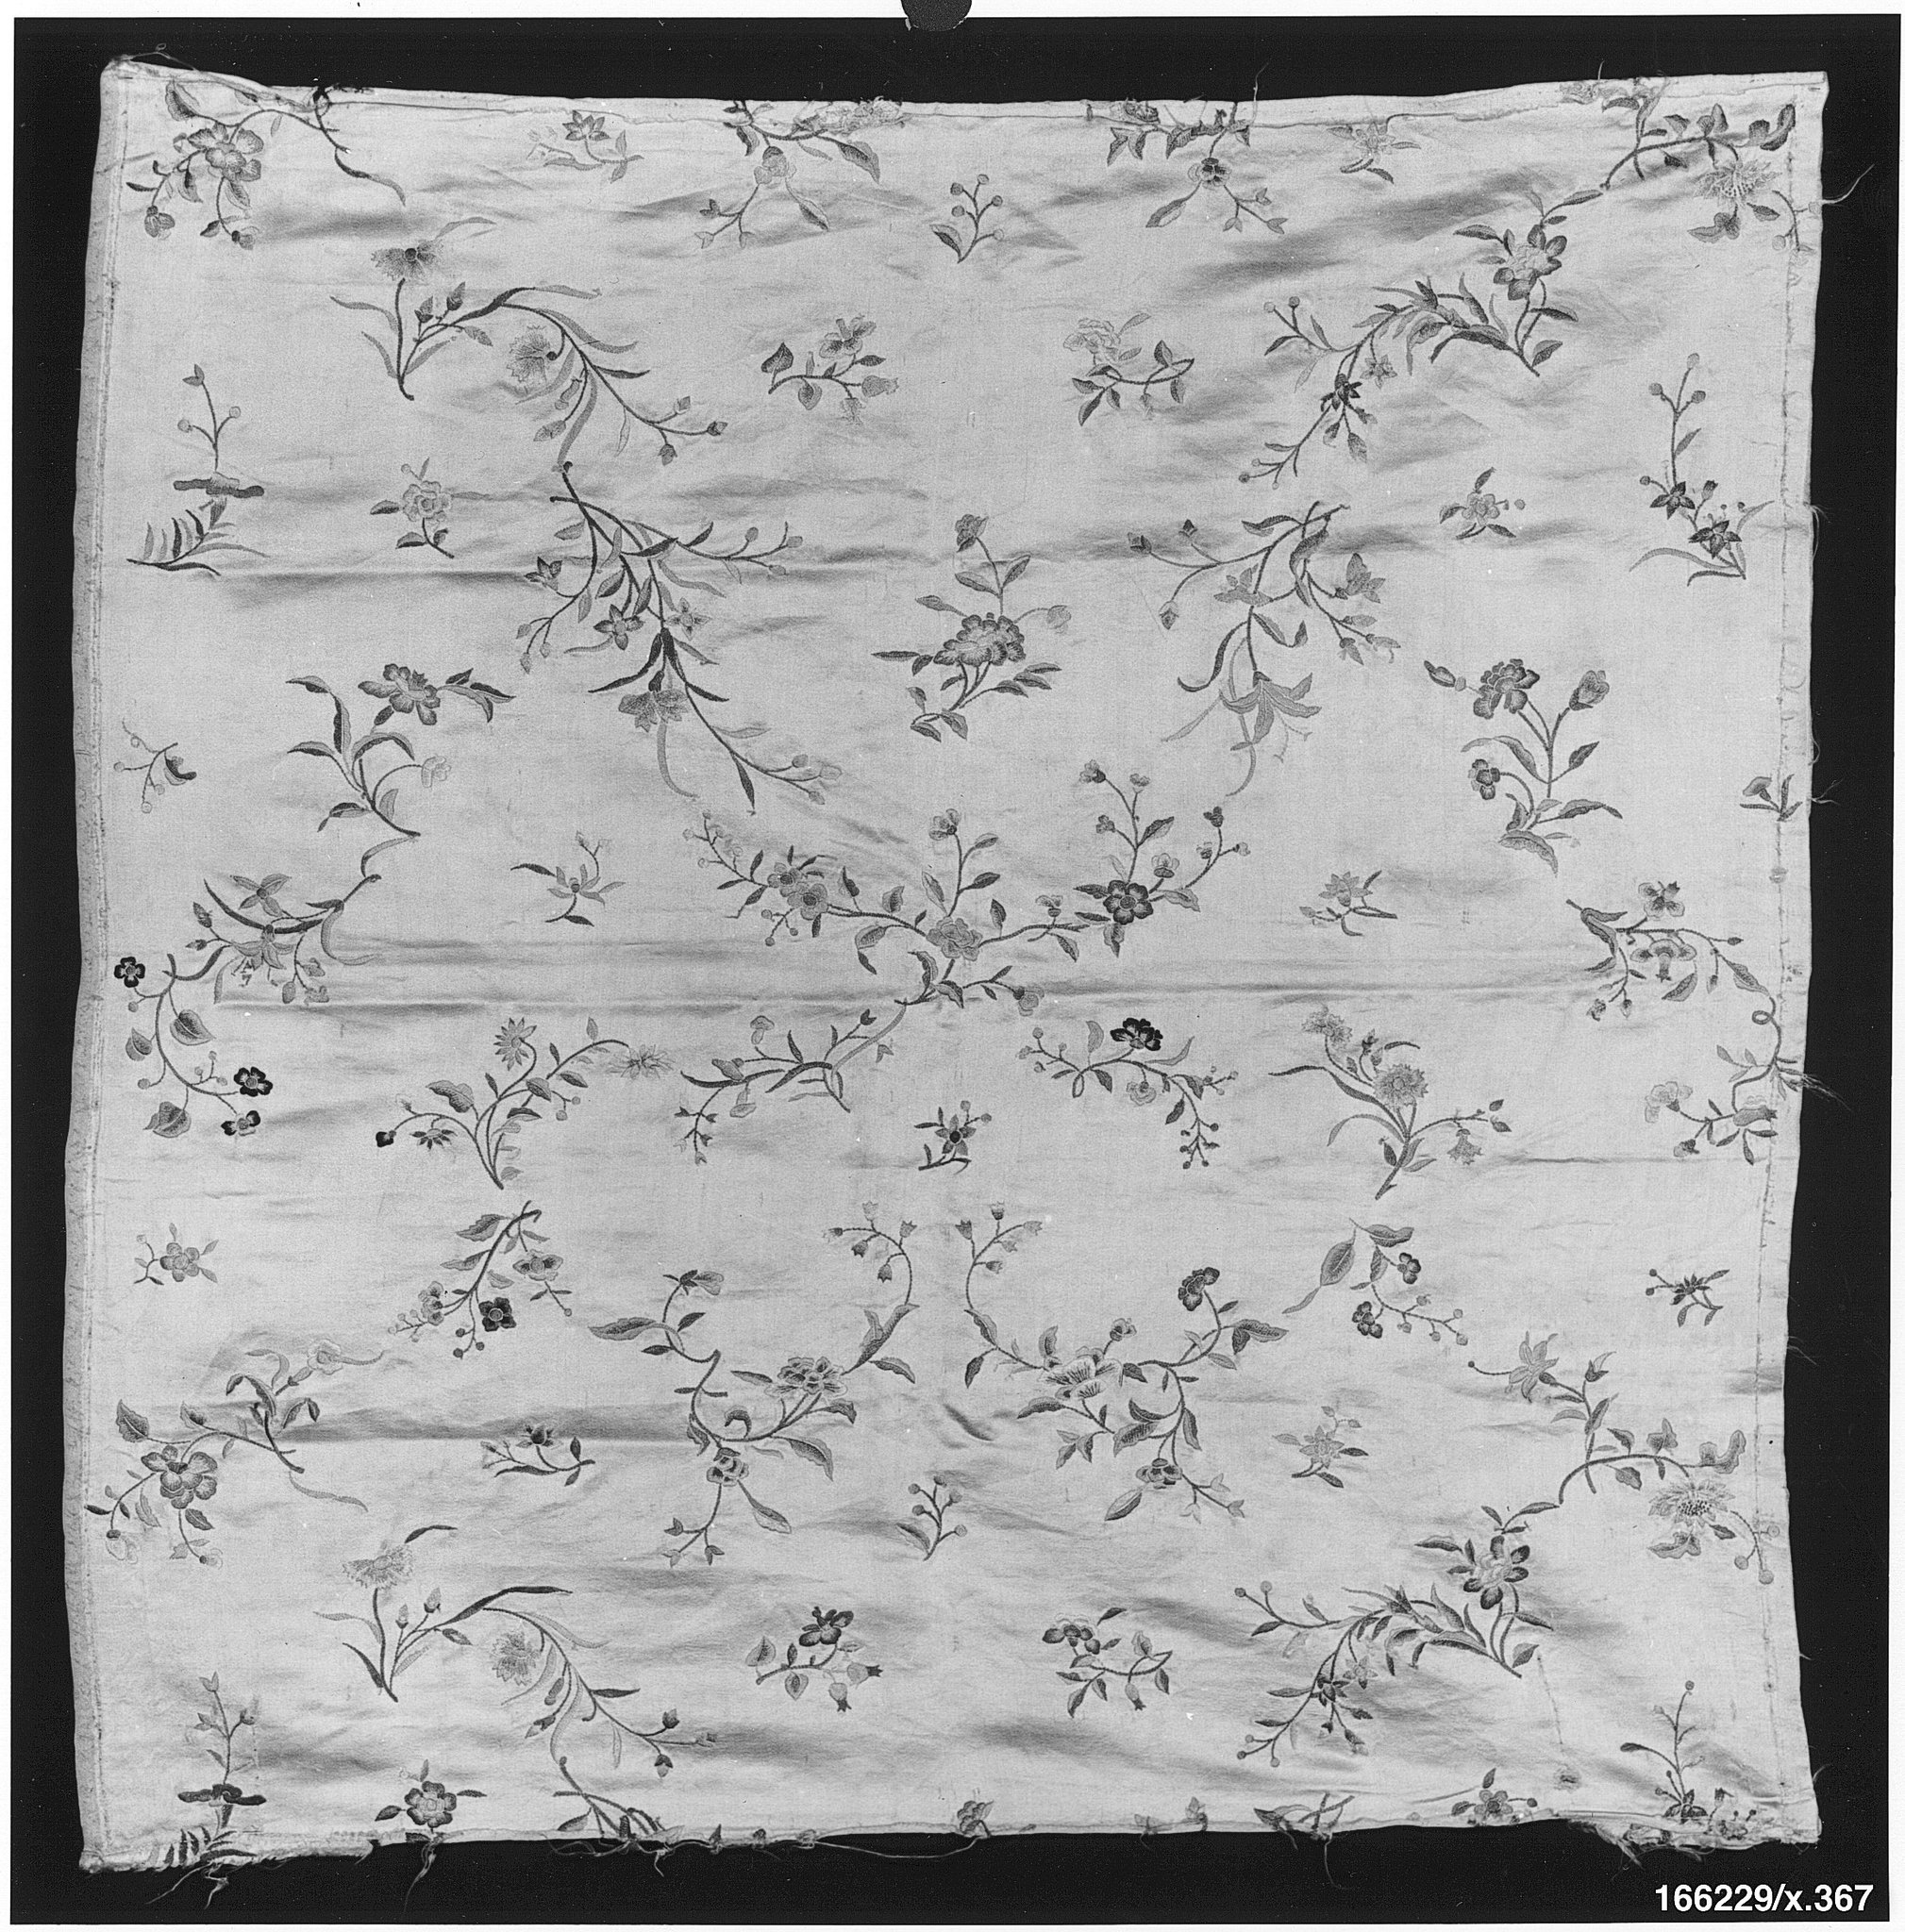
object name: piece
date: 1701-1800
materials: silk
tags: flowers,leaves